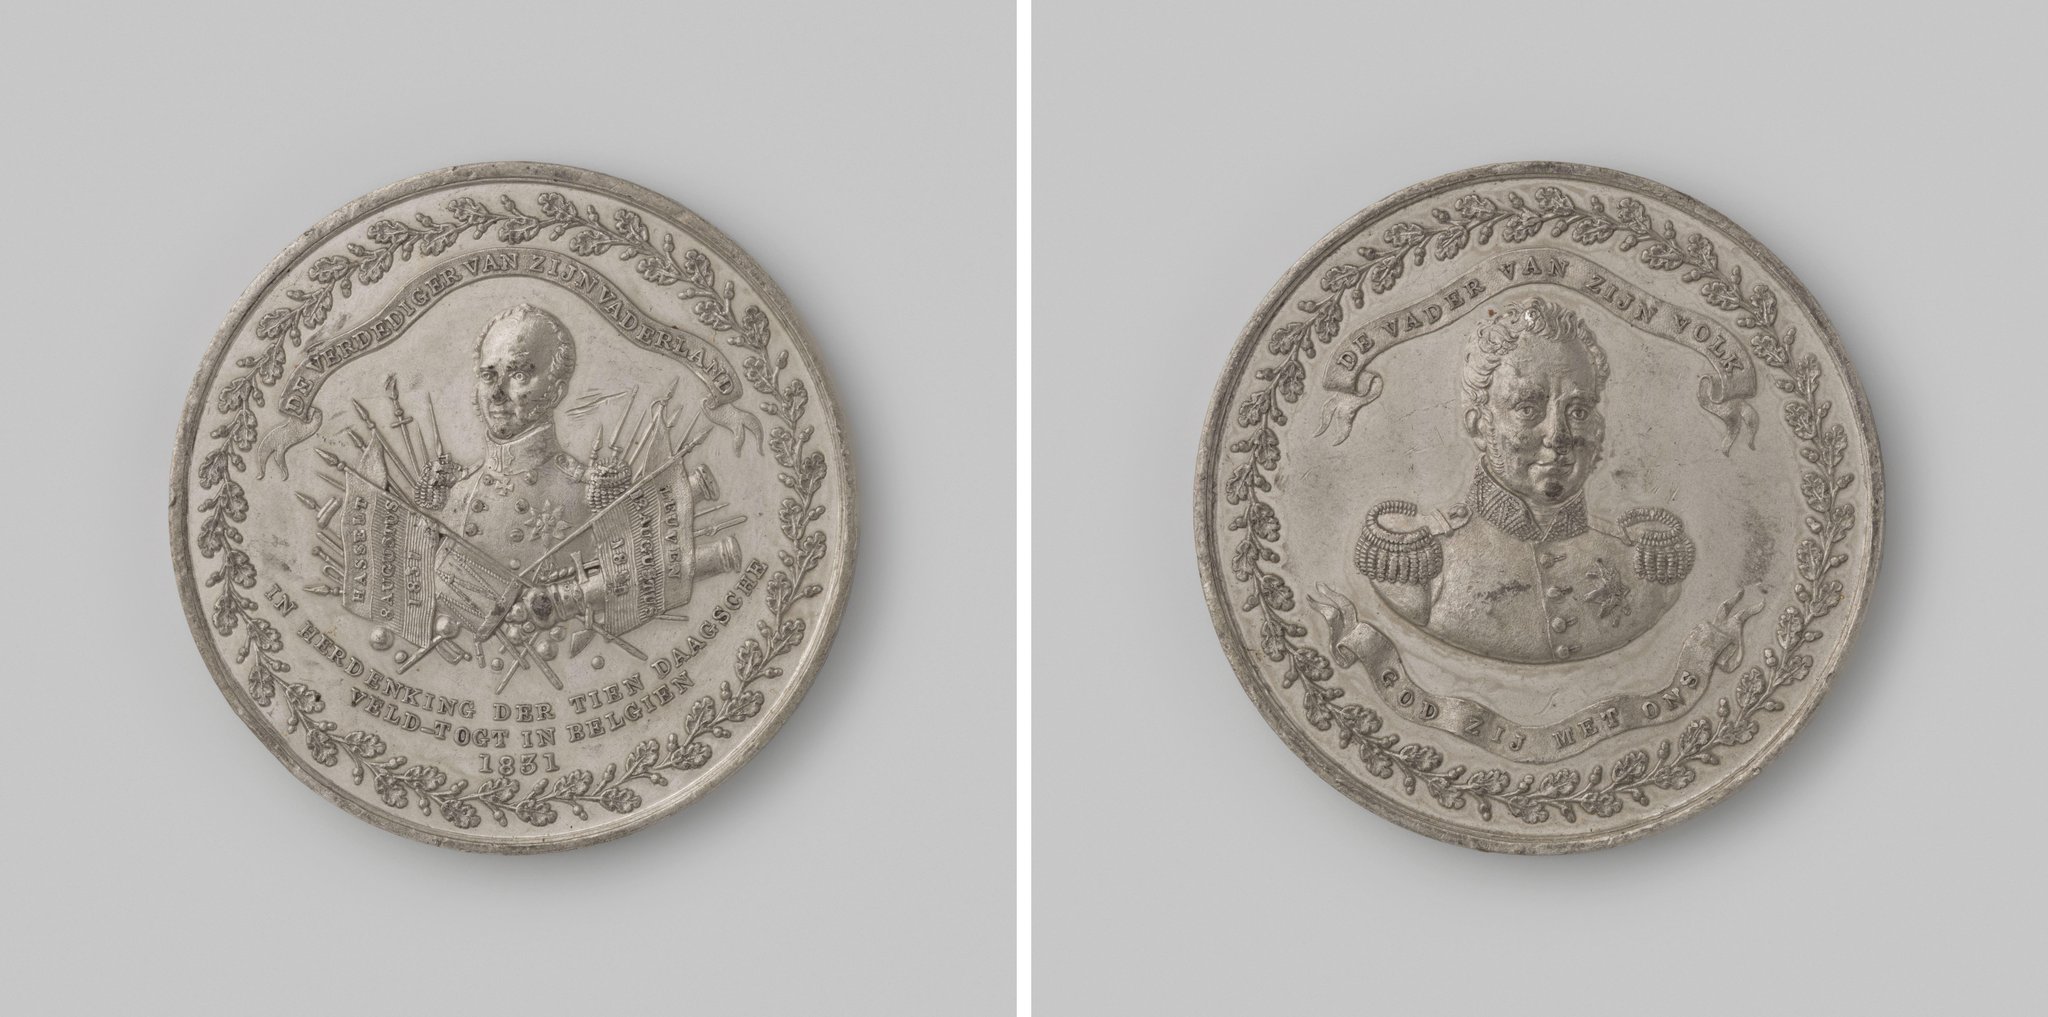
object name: history medal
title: Erepenning op koning Willem I, opperbevelhebber van de Tiendaagse veldtocht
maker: Anonymous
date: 1831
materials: tin